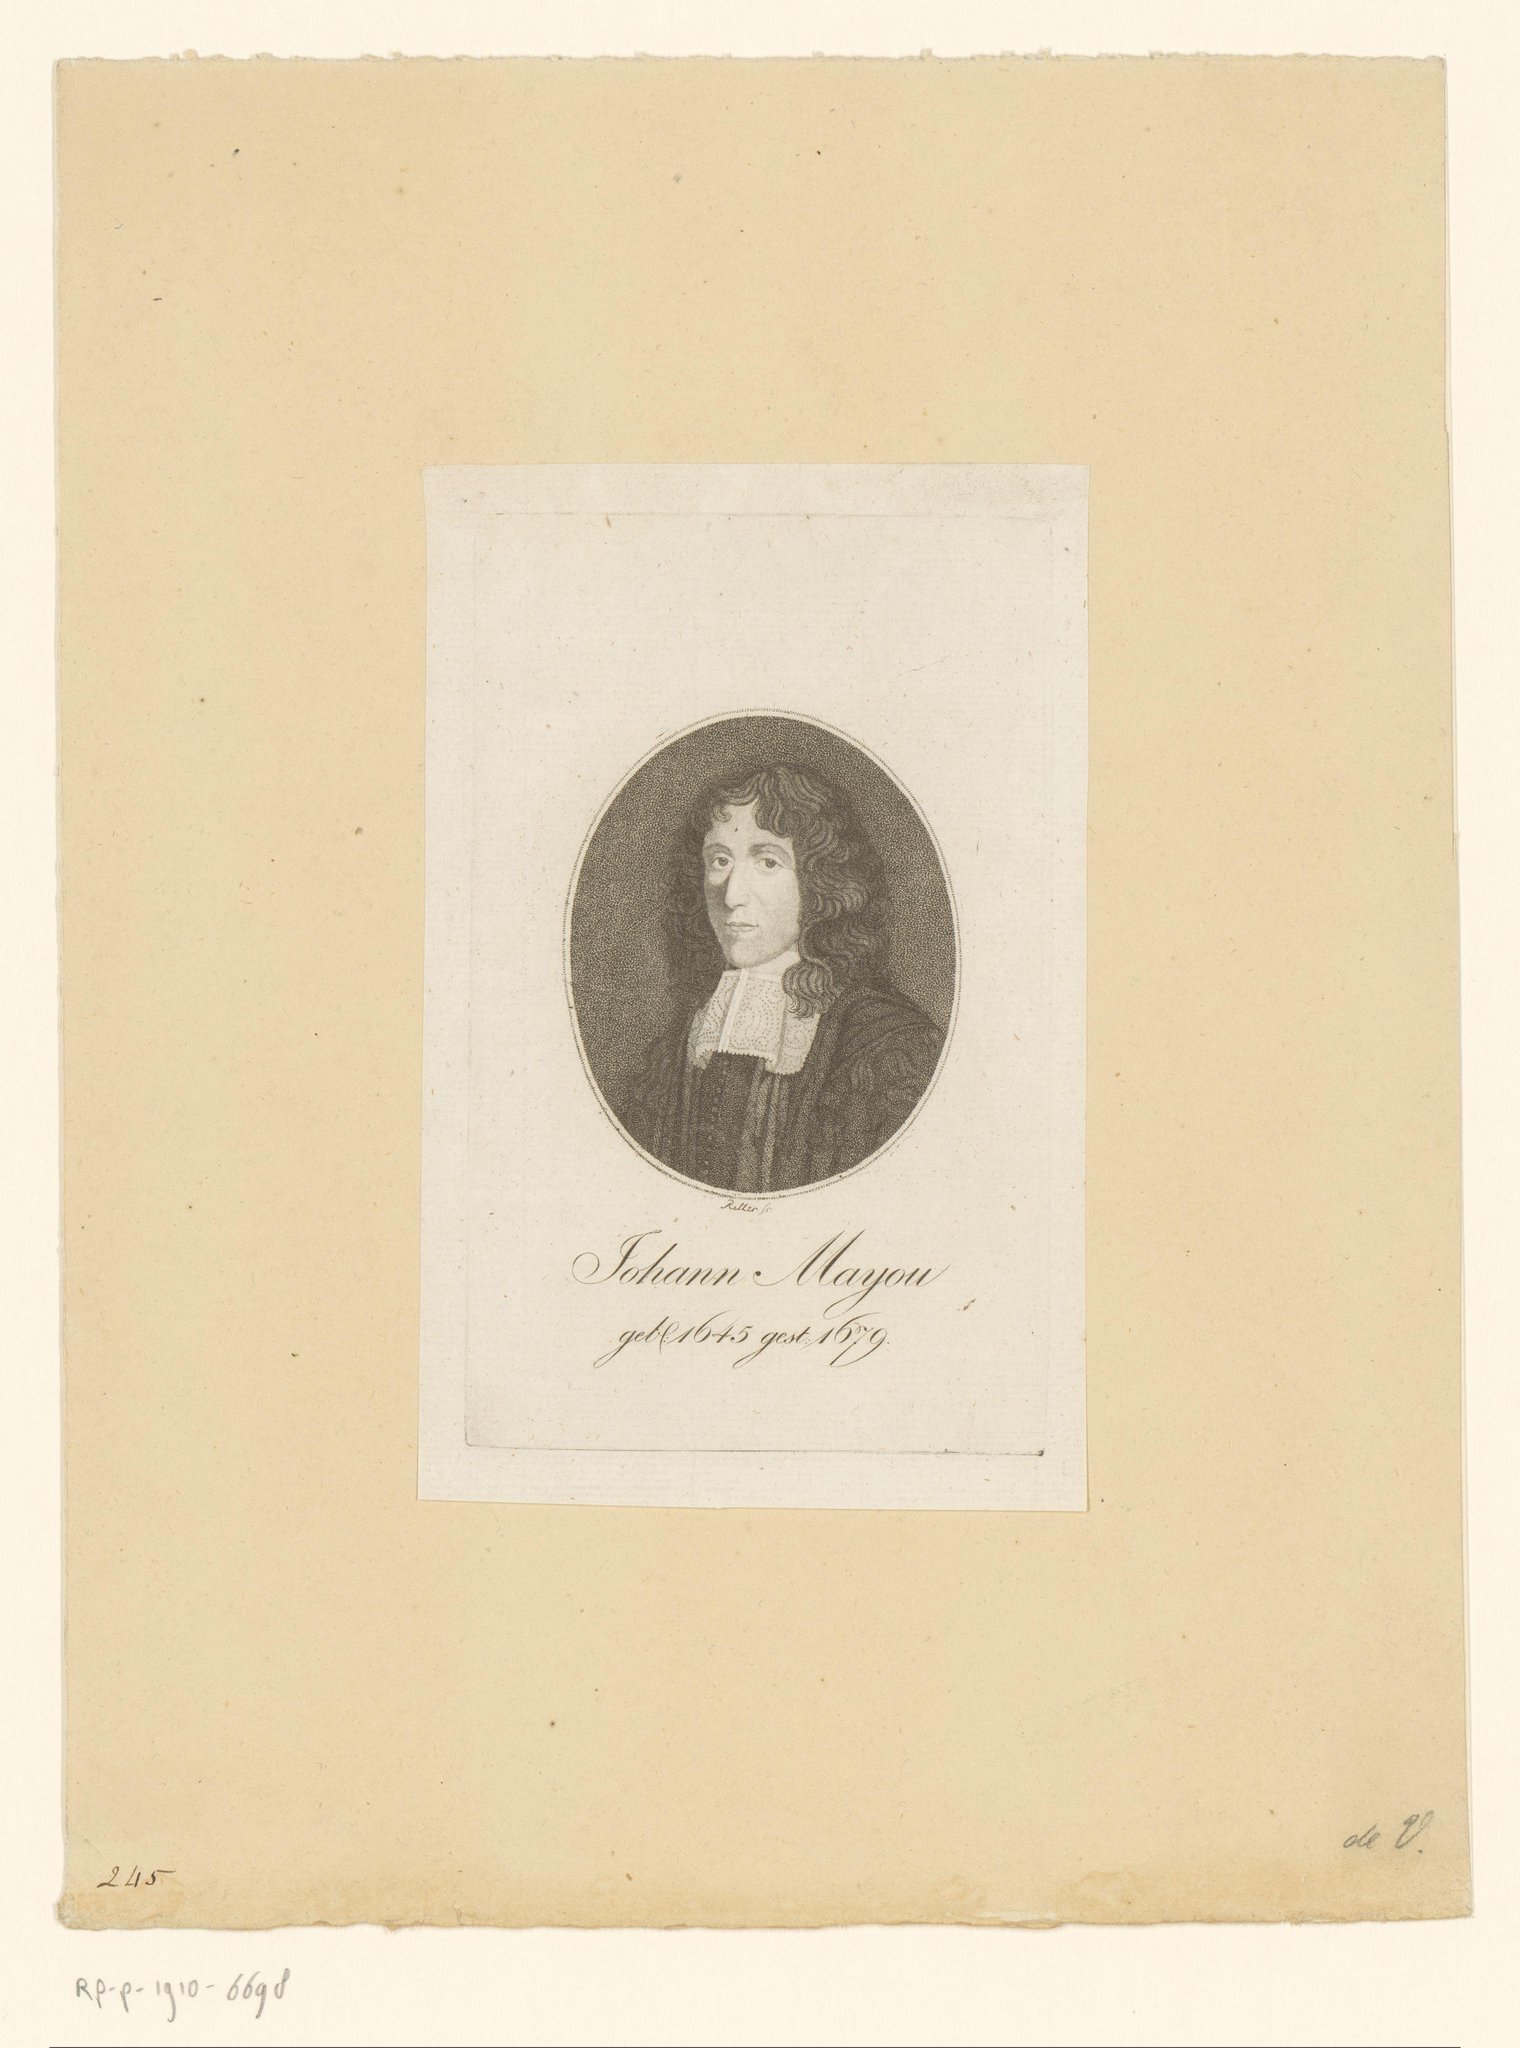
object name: print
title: Portret van John Mayow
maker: heinrich wilhelm ritter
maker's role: print maker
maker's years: -1856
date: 1800-1856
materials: paper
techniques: engraving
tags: london, physicist, historical persons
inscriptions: collector's mark: Lugt 2228